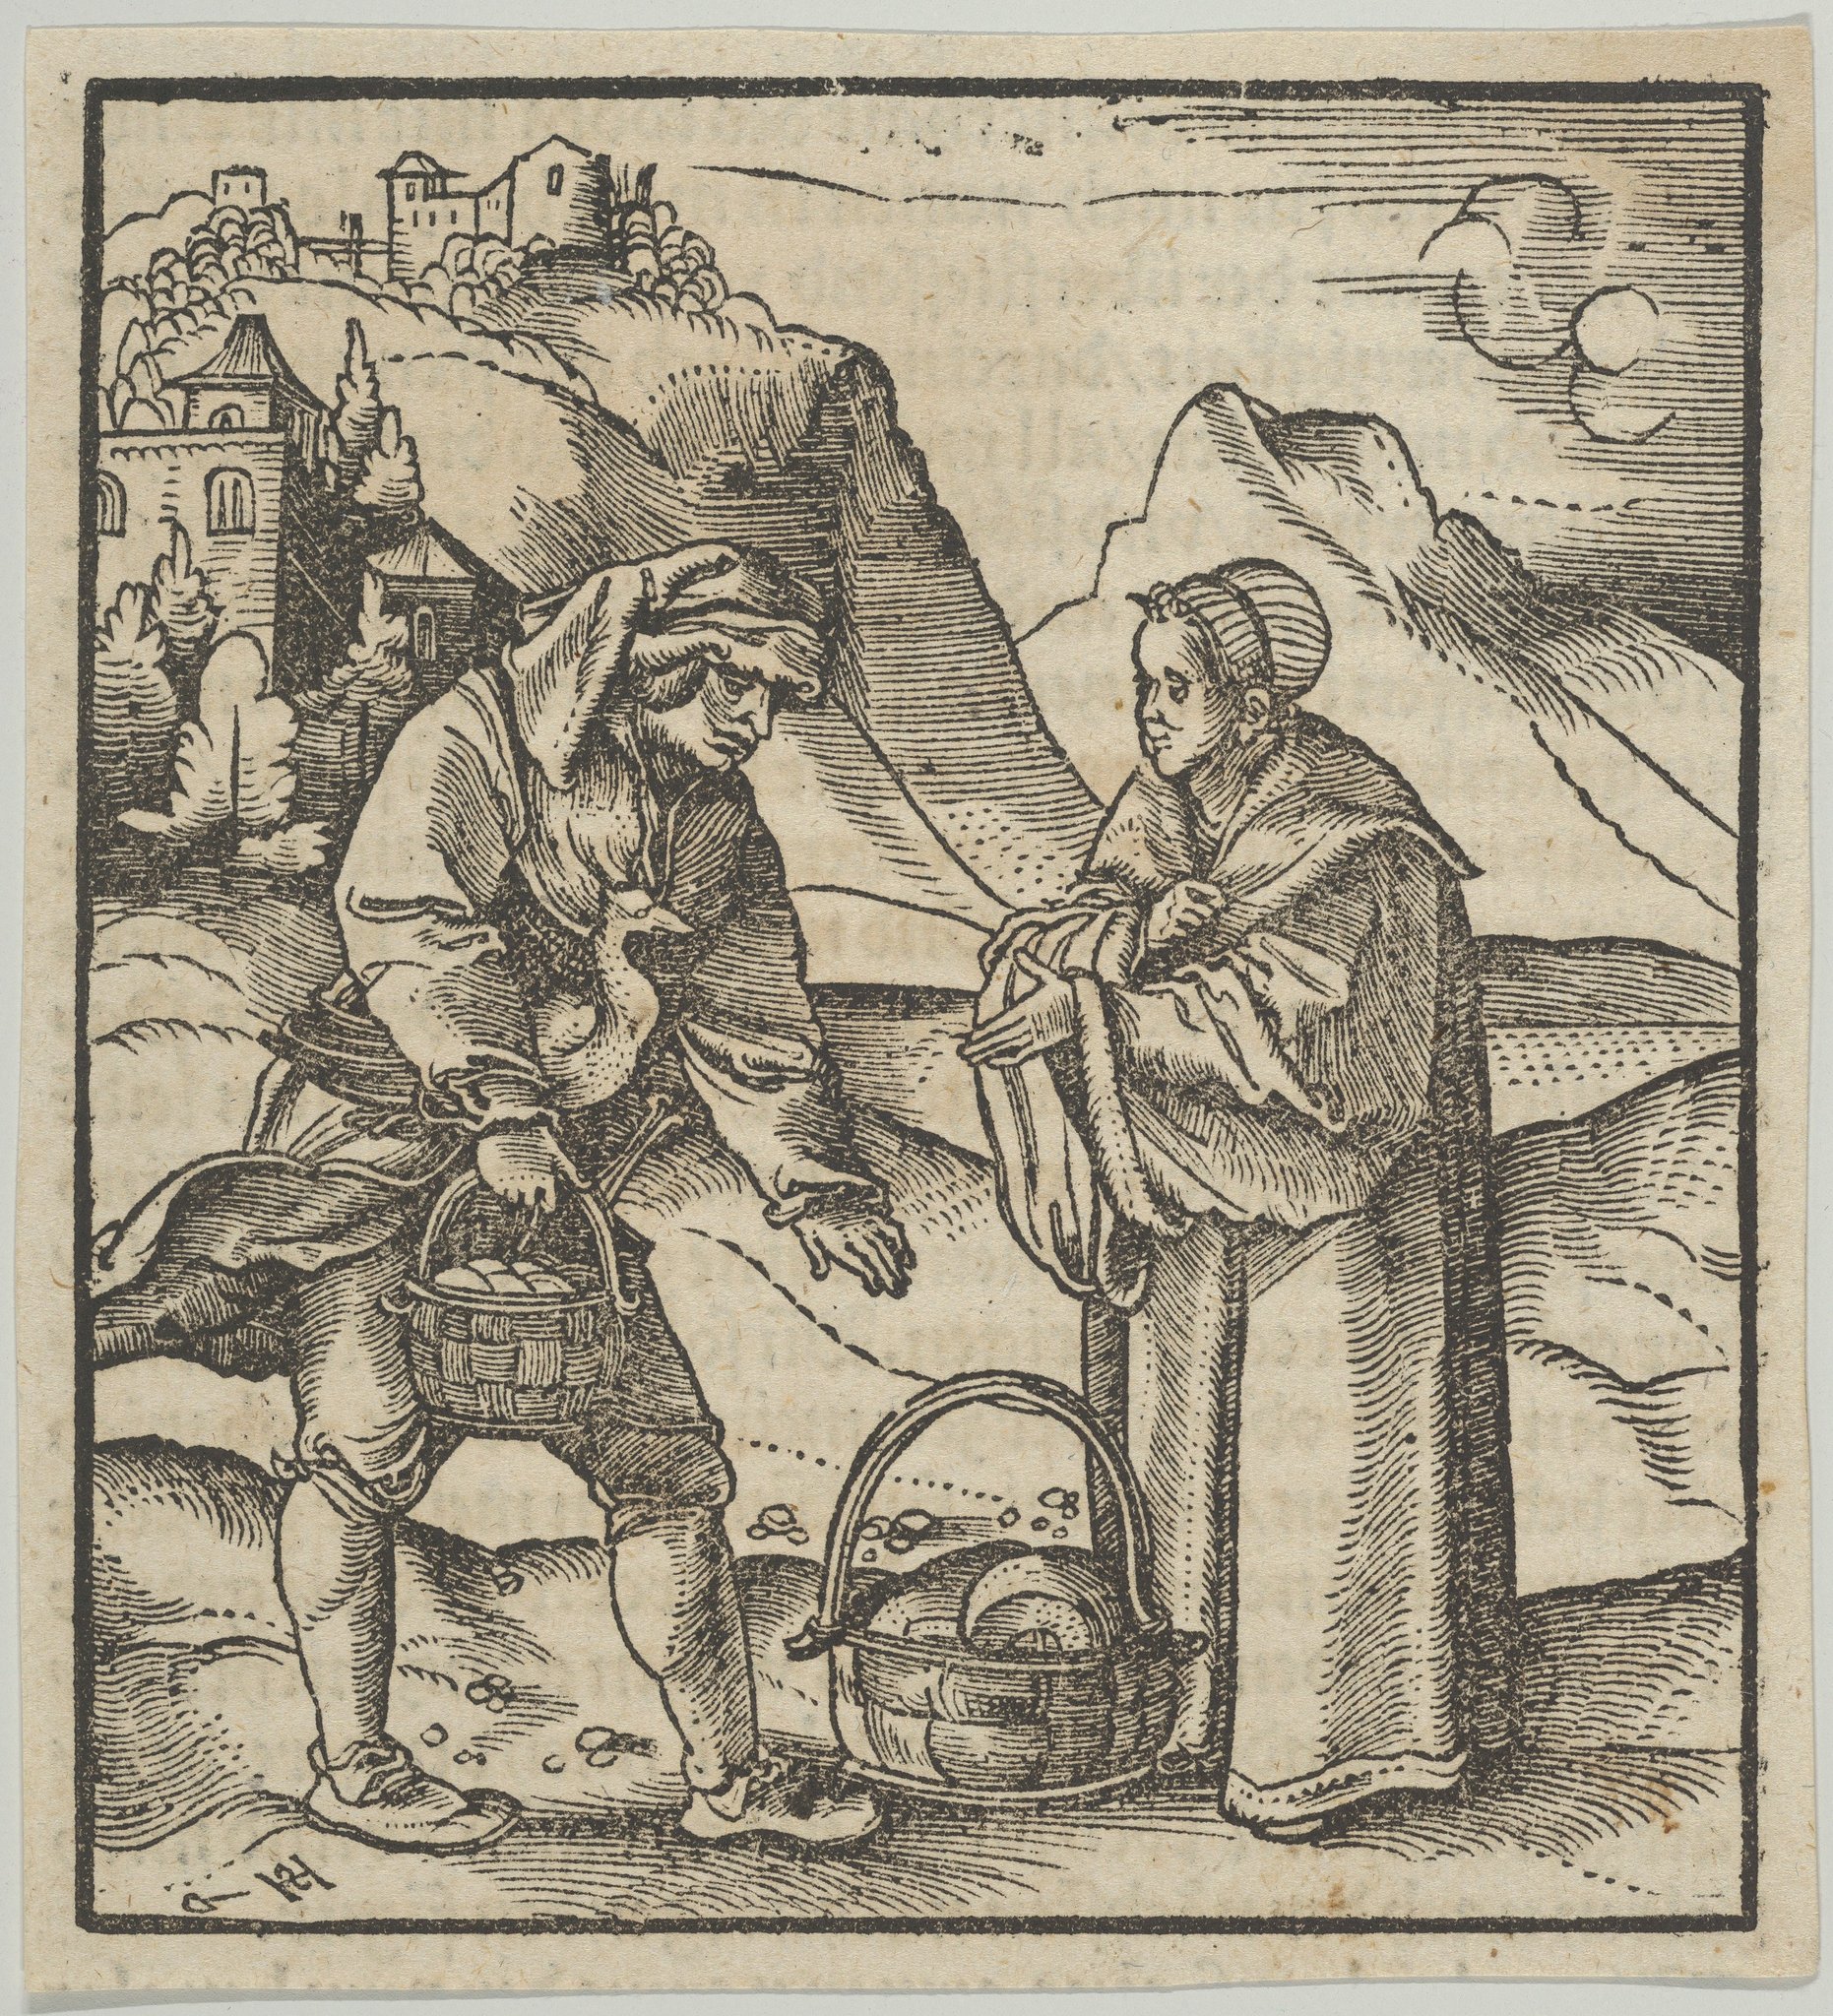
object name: print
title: A Farmer and his Patron, from Hymmelwagen auff dem, wer wol lebt...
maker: hans schäufelein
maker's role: artist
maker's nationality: german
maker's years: 1480-1540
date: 1517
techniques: woodcut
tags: men,women,farmers